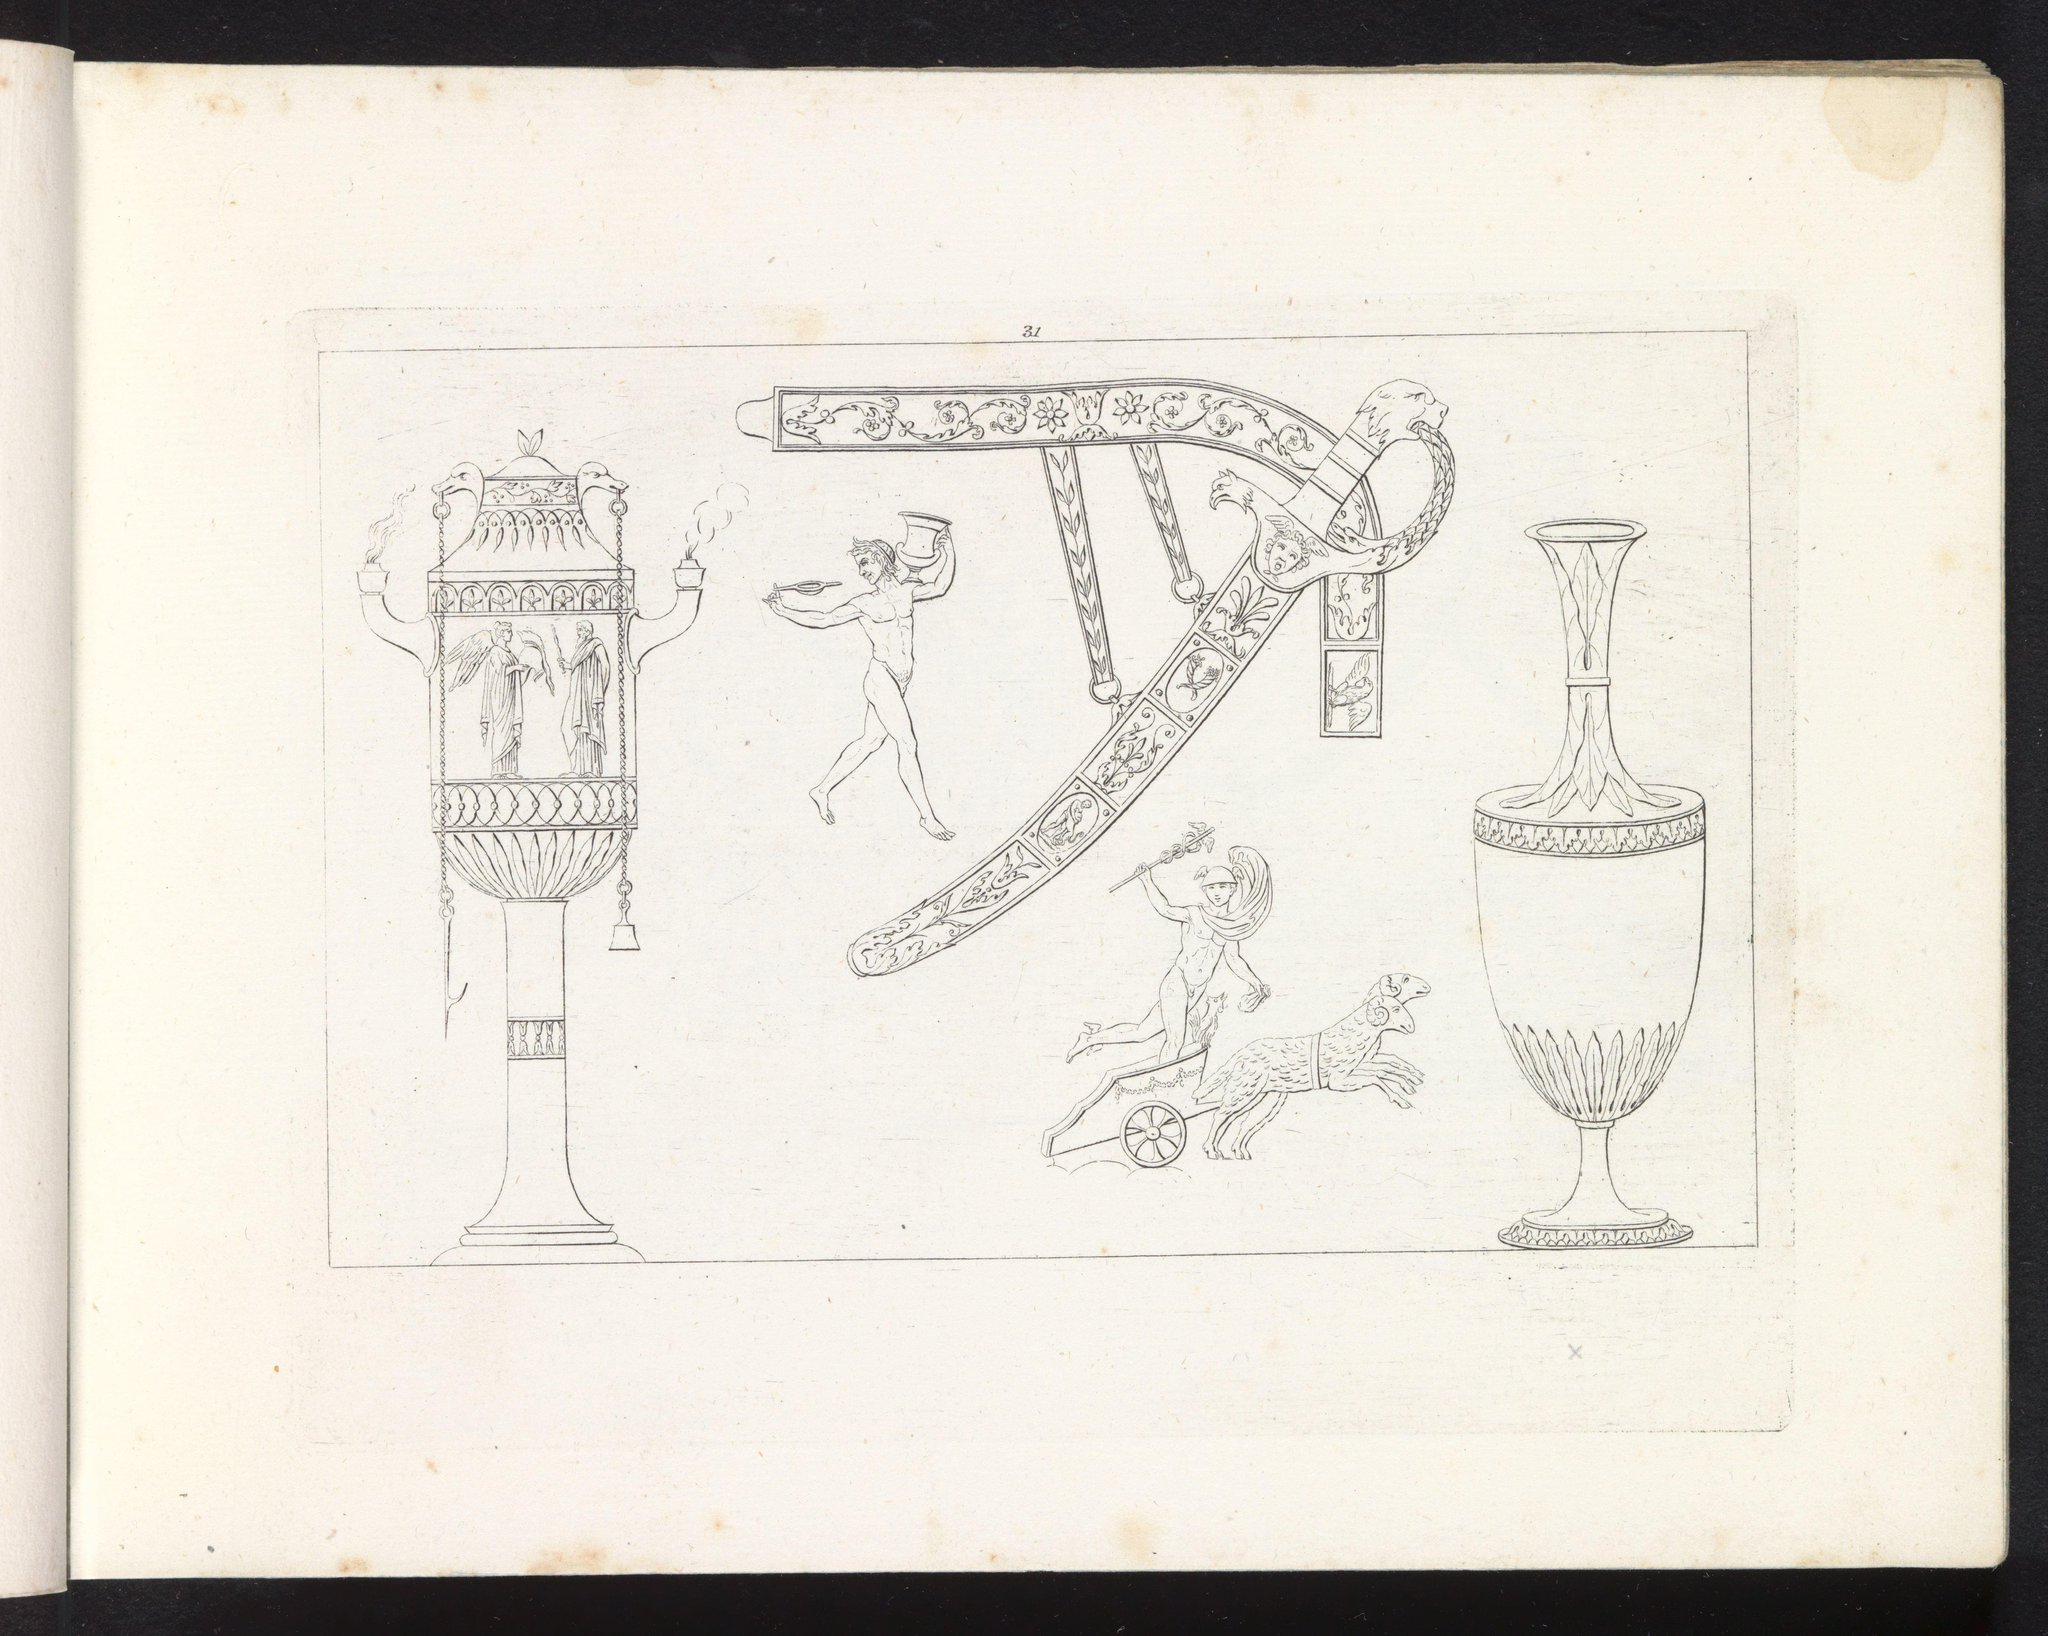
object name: album leaf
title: Invenzioni diverse di mobili ed utensili sacri e profani per usi comuni della vita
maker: pietro ruga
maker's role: print maker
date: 1817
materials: paper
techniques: etching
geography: italy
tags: ornaments ~ art, censer, vase ~ ornament, scabbard, sheath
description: Prent maakt deel uit van een reeks van 100 prenten (+ titelprent) met ontwerpen voor religieuze en profane voorwerpen.